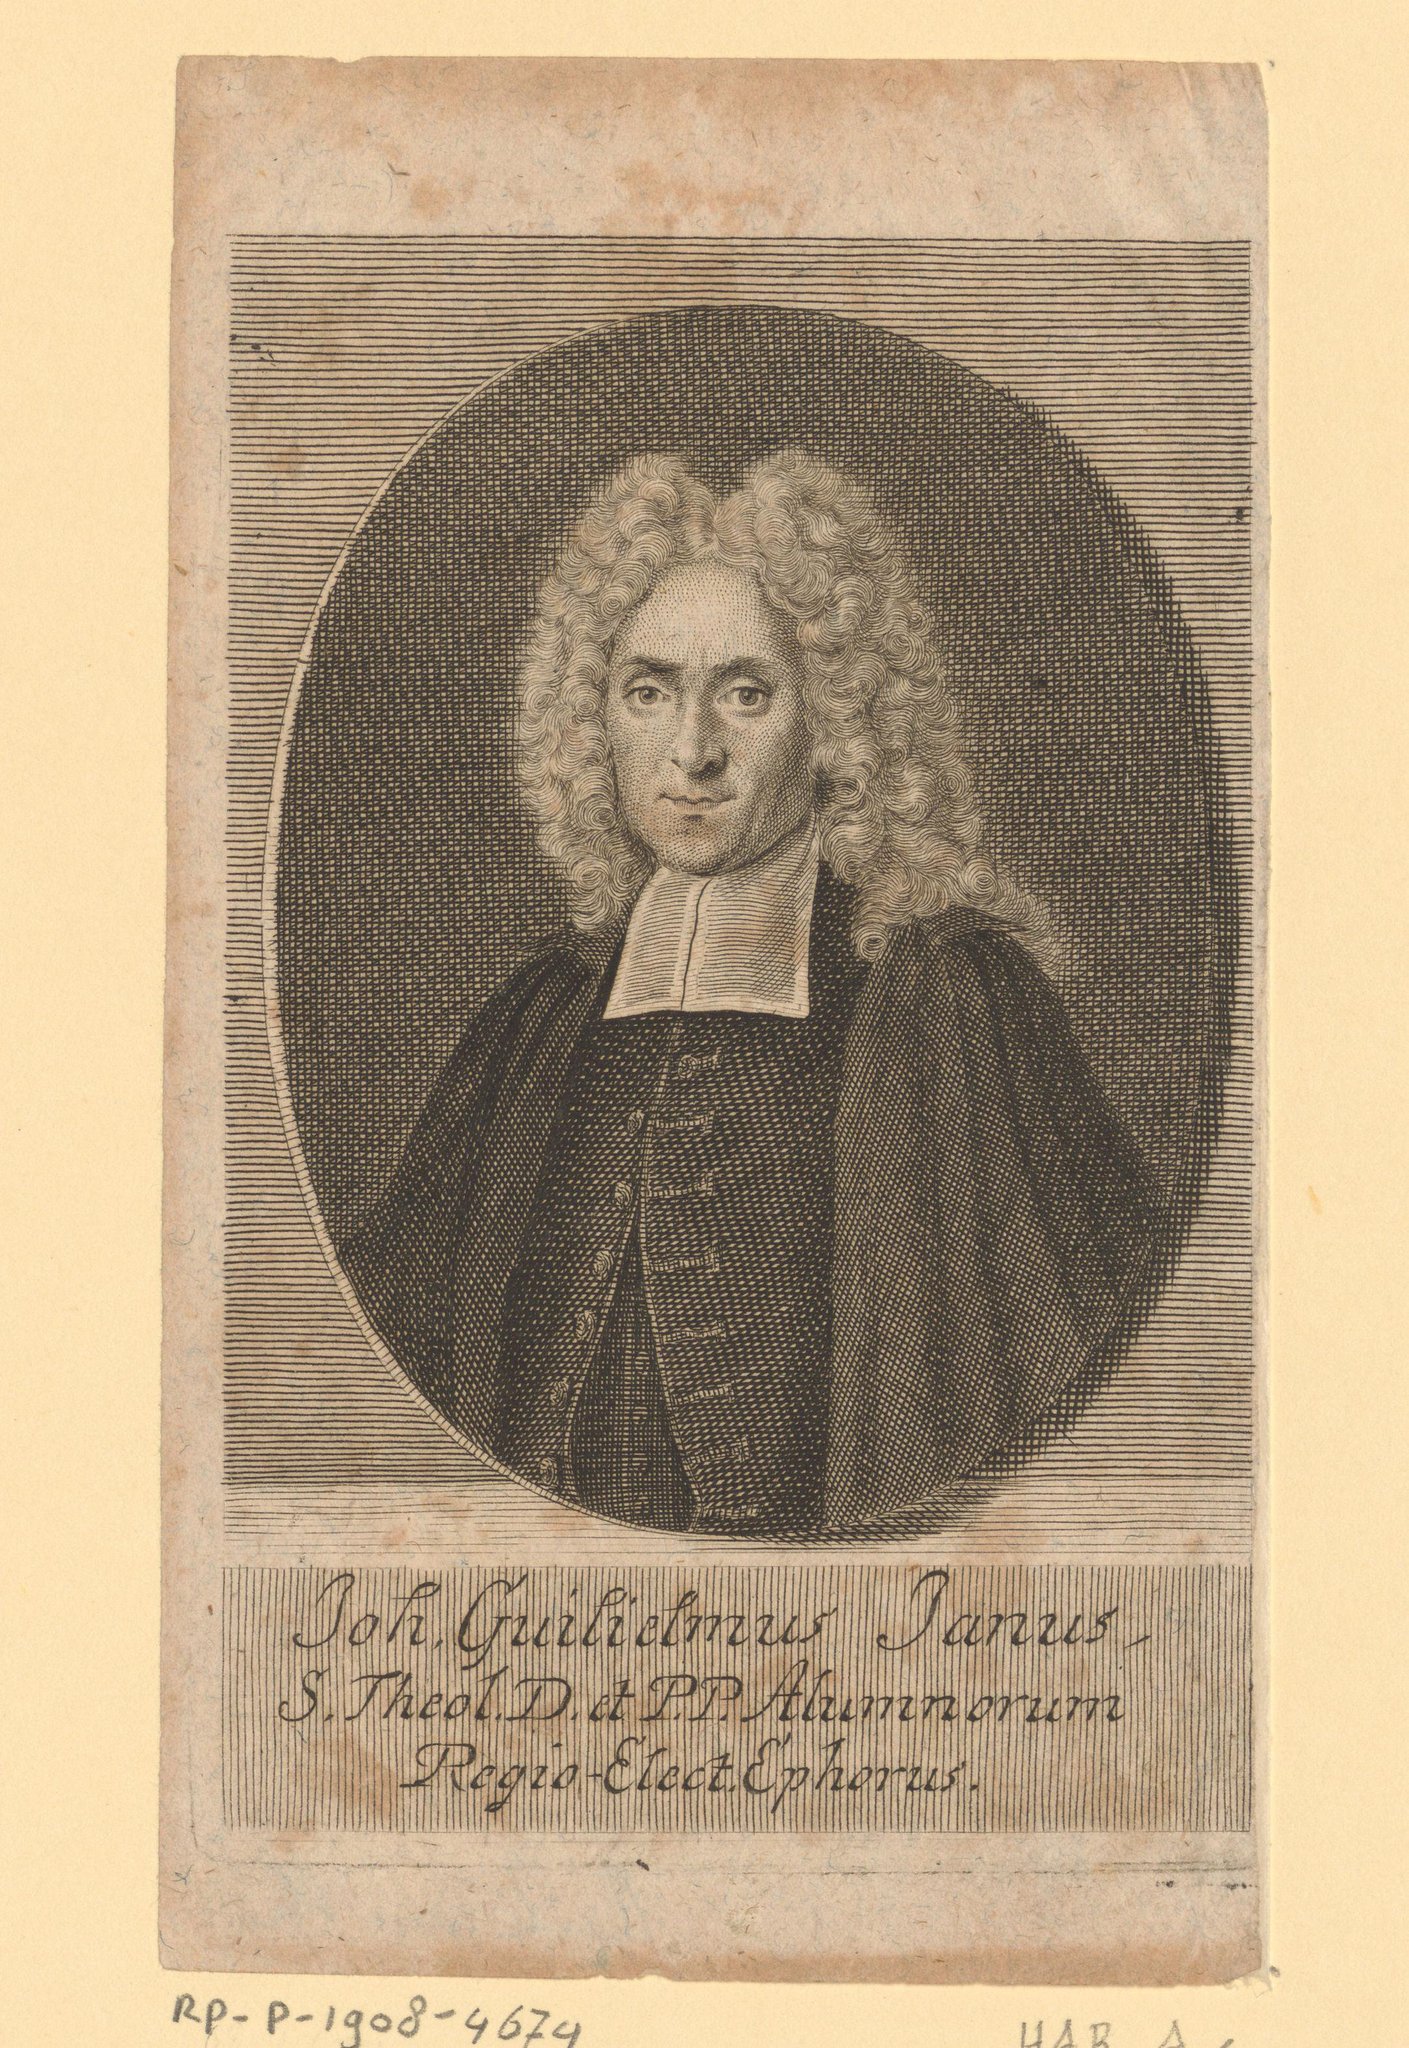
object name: print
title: Portret van Johann Wilhelm Jahn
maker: martin bernigeroth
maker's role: print maker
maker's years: 1670-1733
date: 1700-1733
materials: paper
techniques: engraving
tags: theologian, historical persons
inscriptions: collector's mark: Lugt 2228